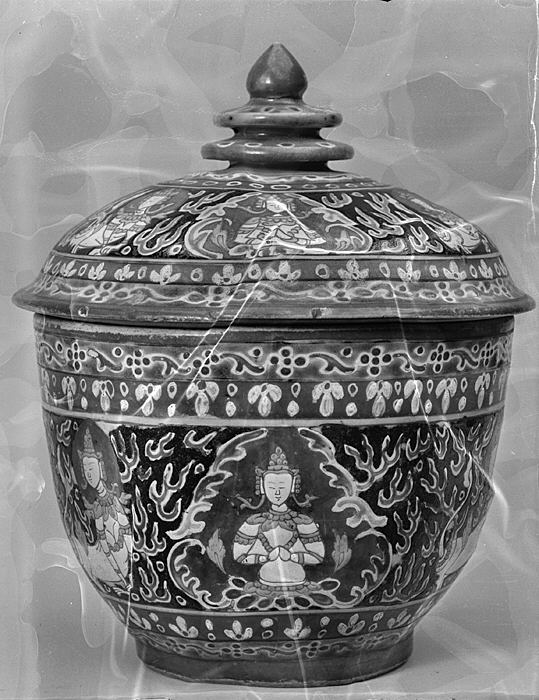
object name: covered bowl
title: Covered bowl with Thai mythical figures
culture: chinese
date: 1801-1900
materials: enamel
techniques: overglaze, painting, polychrome